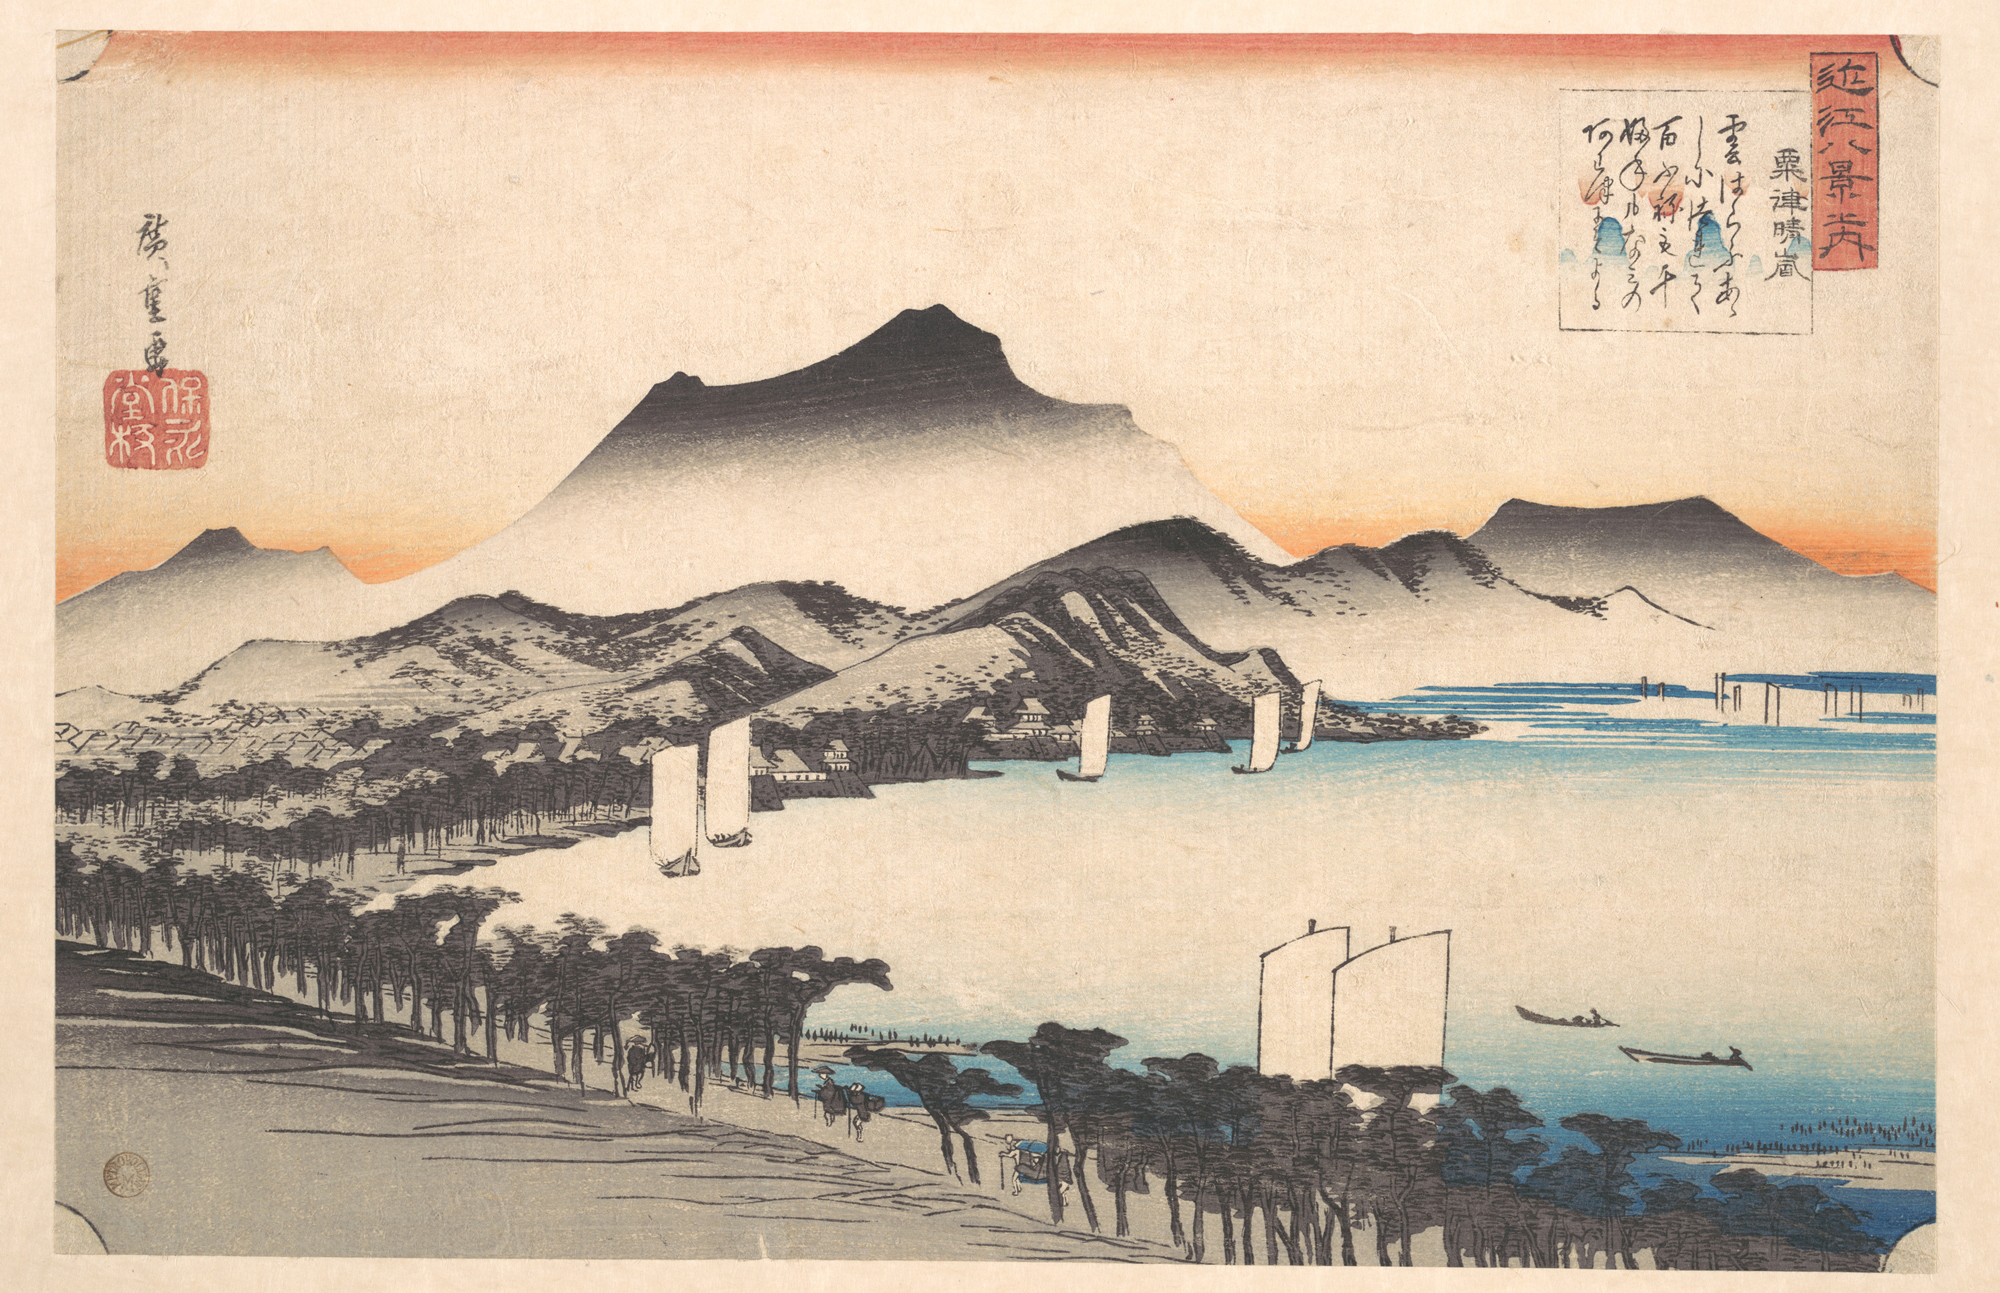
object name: print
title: Clearing Weather at Awazu, Lake Biwa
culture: japanese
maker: utagawa hiroshige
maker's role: artist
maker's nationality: japanese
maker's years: 1797-1858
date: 1835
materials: ink, paper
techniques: woodblock print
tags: lakes,mountains,landscapes,boats